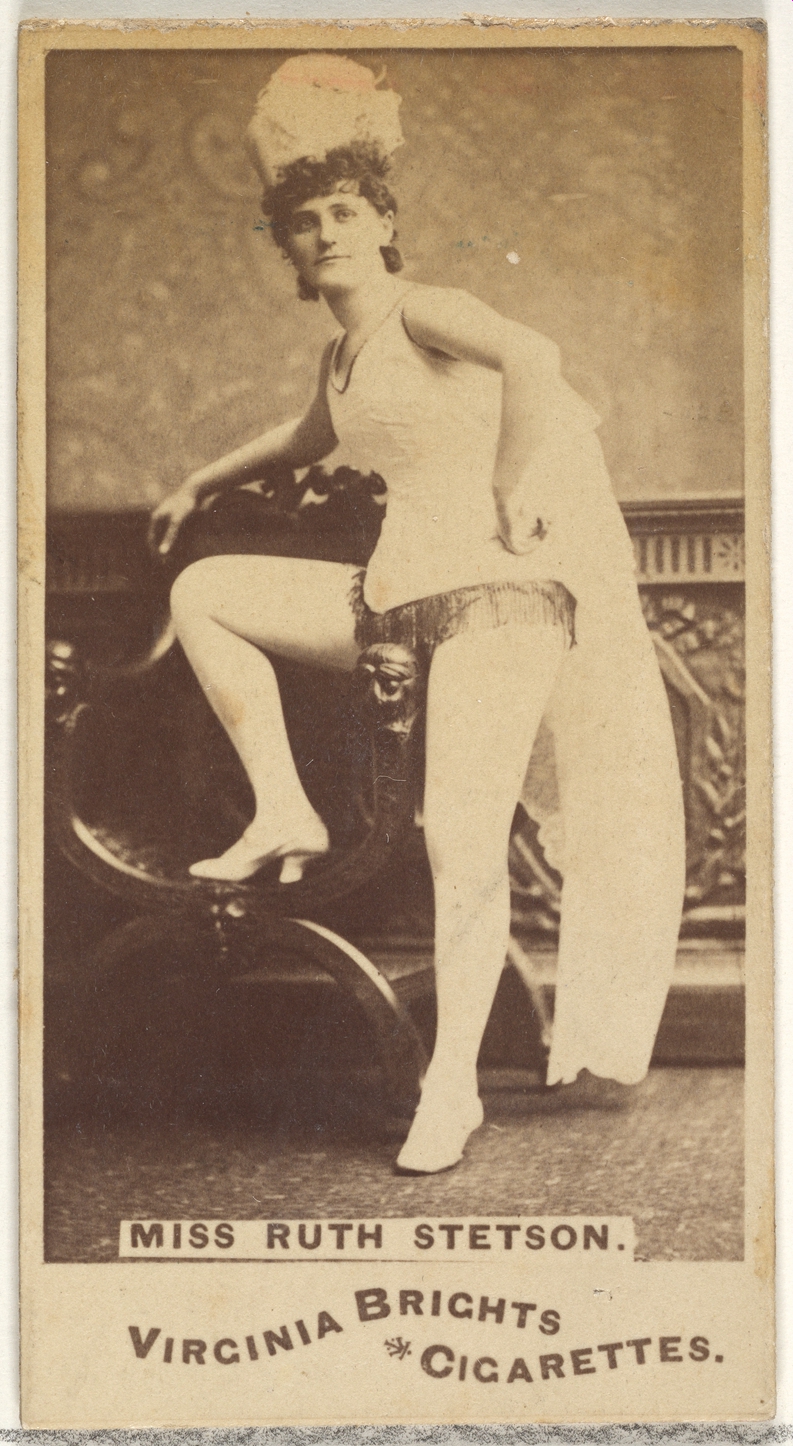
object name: photograph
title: Miss Ruth Stetson, from the Actors and Actresses series (N45, Type 1) for Virginia Brights Cigarettes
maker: allen & ginter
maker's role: publisher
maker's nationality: american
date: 1888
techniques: albumen silver print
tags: portraits,women,actresses